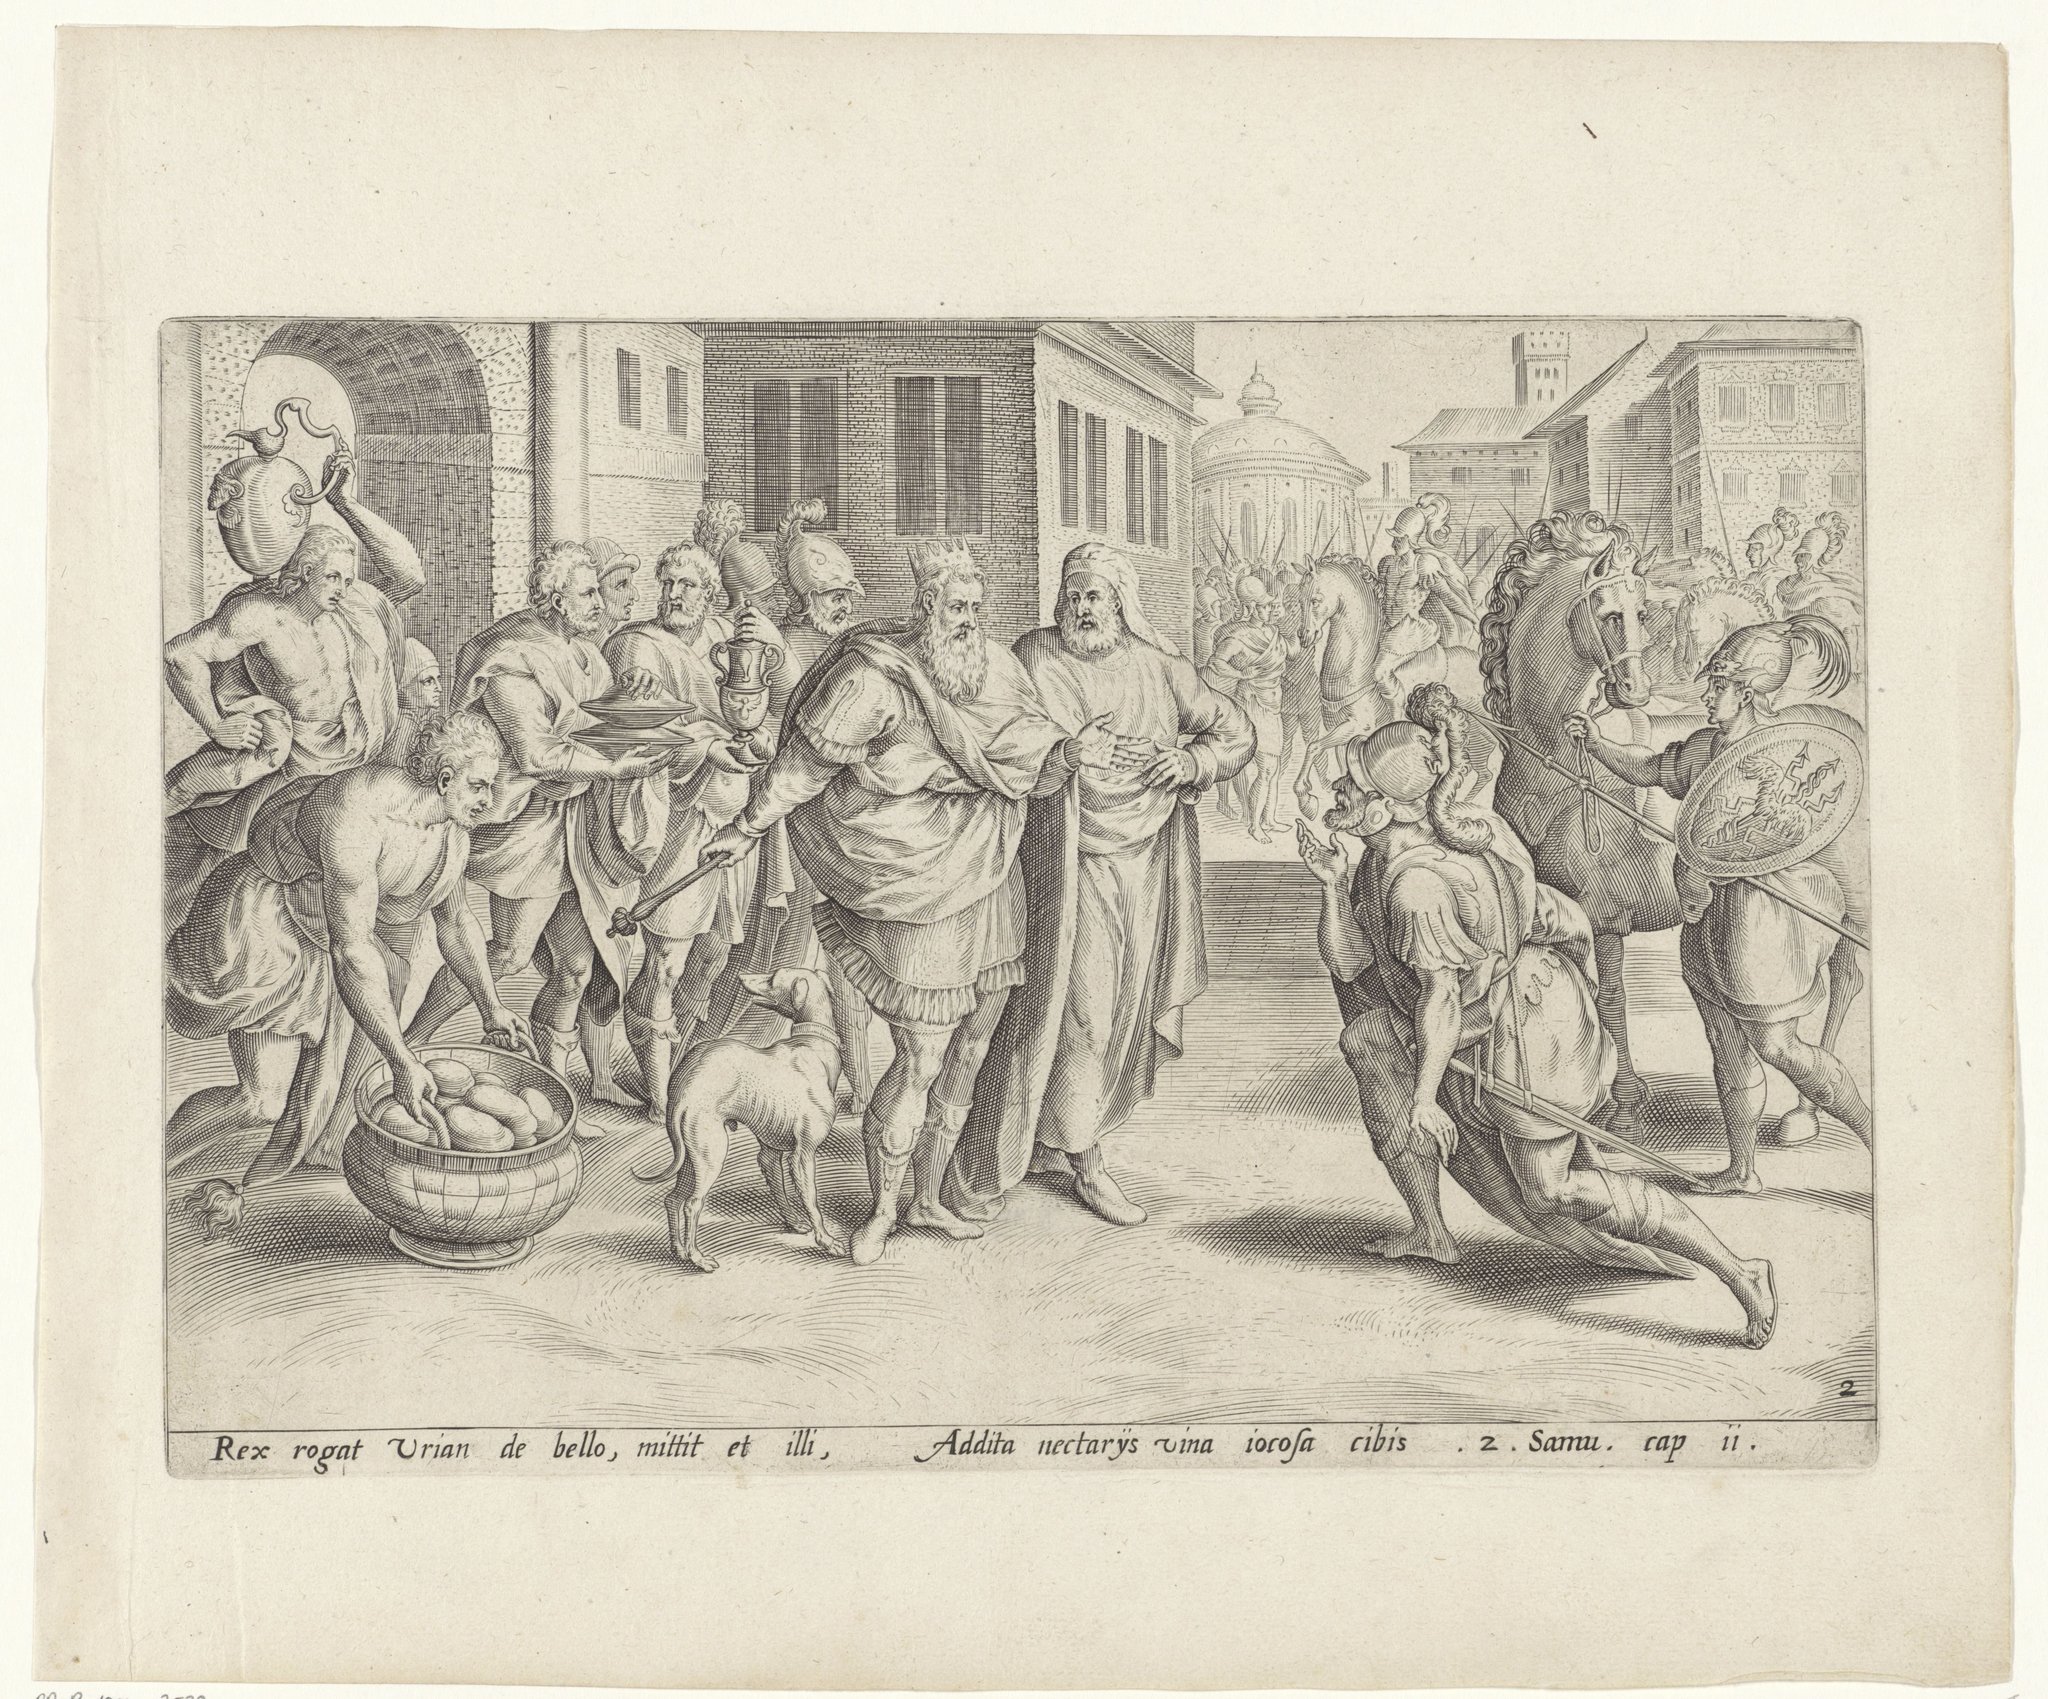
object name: print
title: Theatrum biblicum (...)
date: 1579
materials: paper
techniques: engraving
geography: amsterdam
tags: david speaks to uriah, the soldier; the soldier's life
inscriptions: collector's mark: Lugt 2228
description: Koning David heeft Uria, de man van Batseba, teruggeroepen uit de oorlog. Uria knielt, gekleed in zijn wapenrusting, voor hem neer. David dringt er bij Uria op aan om te ontspannen en de door knechten gebrachte wijn en het voedel aan te nemen. Uria gaat echter niet naar huis om bij zijn vrouw Batseba te slapen. Onder de voorstelling een verwijzing in het Latijn naar de Bijbeltekst in 2 Sam. 11.